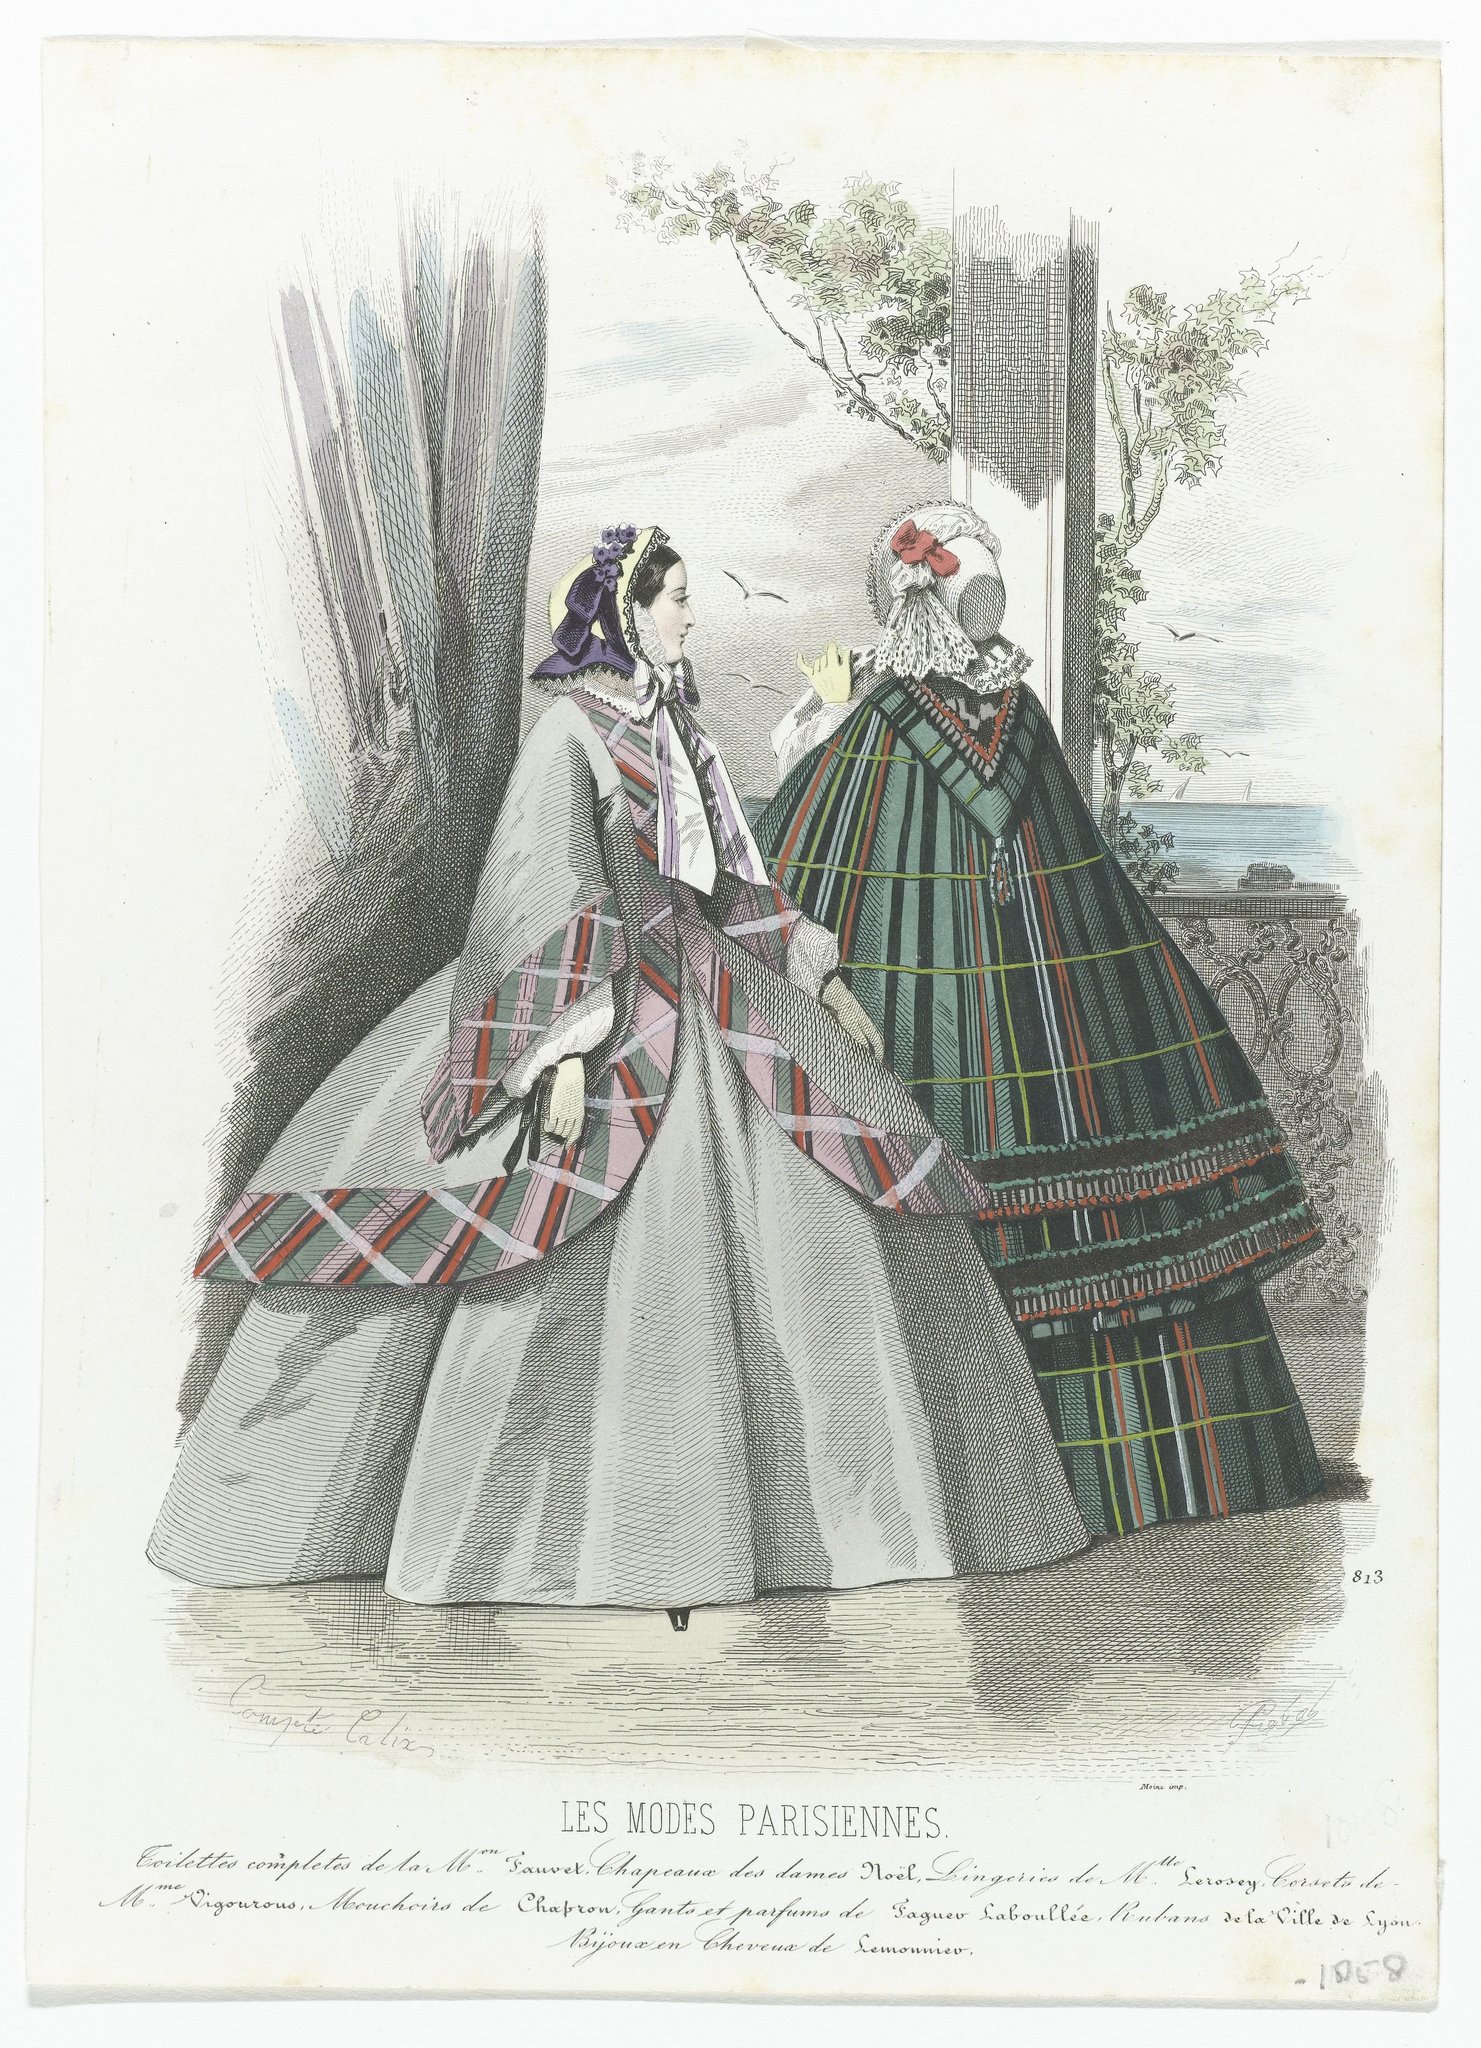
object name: fashion print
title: An Explosion of Fashion Magazines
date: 1858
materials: paper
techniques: engraving, hand coloring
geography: paris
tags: clothing for the upper part of the body (+ women's clothes), handkerchief (+ women's clothes), border, ribbon, braid (+ women's clothes), skirt (crinoline skirt) (+ women's clothes), cape (+ women's clothes), fashion plates, head-gear: hat (+ women's clothes), gloves, mittens, etc. (+ women's clothes), sea (seascape), sleeves (+ women's clothes)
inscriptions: caption: ‘Toilettes completes de la M"on Fauvet. Chapeaux des dames Noël, Lingeries de M"lle Lerosey. Corsets de M"me Vigourous. Mouchoirs de Chapron. Gants et parfums de Faguer Laboullée. Rubans de la Ville de Lyon. Bijoux en Cheveux de Lemonnier.’, title: ‘Les Modes Parisiennes’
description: Starting from the 1850s, fashion magazines became more affordable and acquired a wider readership. The invention of the sewing machine around 1850 made it easier for people to make their own clothes. Ready-made garments were now also on offer, with fashion plates providing vendor addresses, such as the Maison Gagelin in Paris.